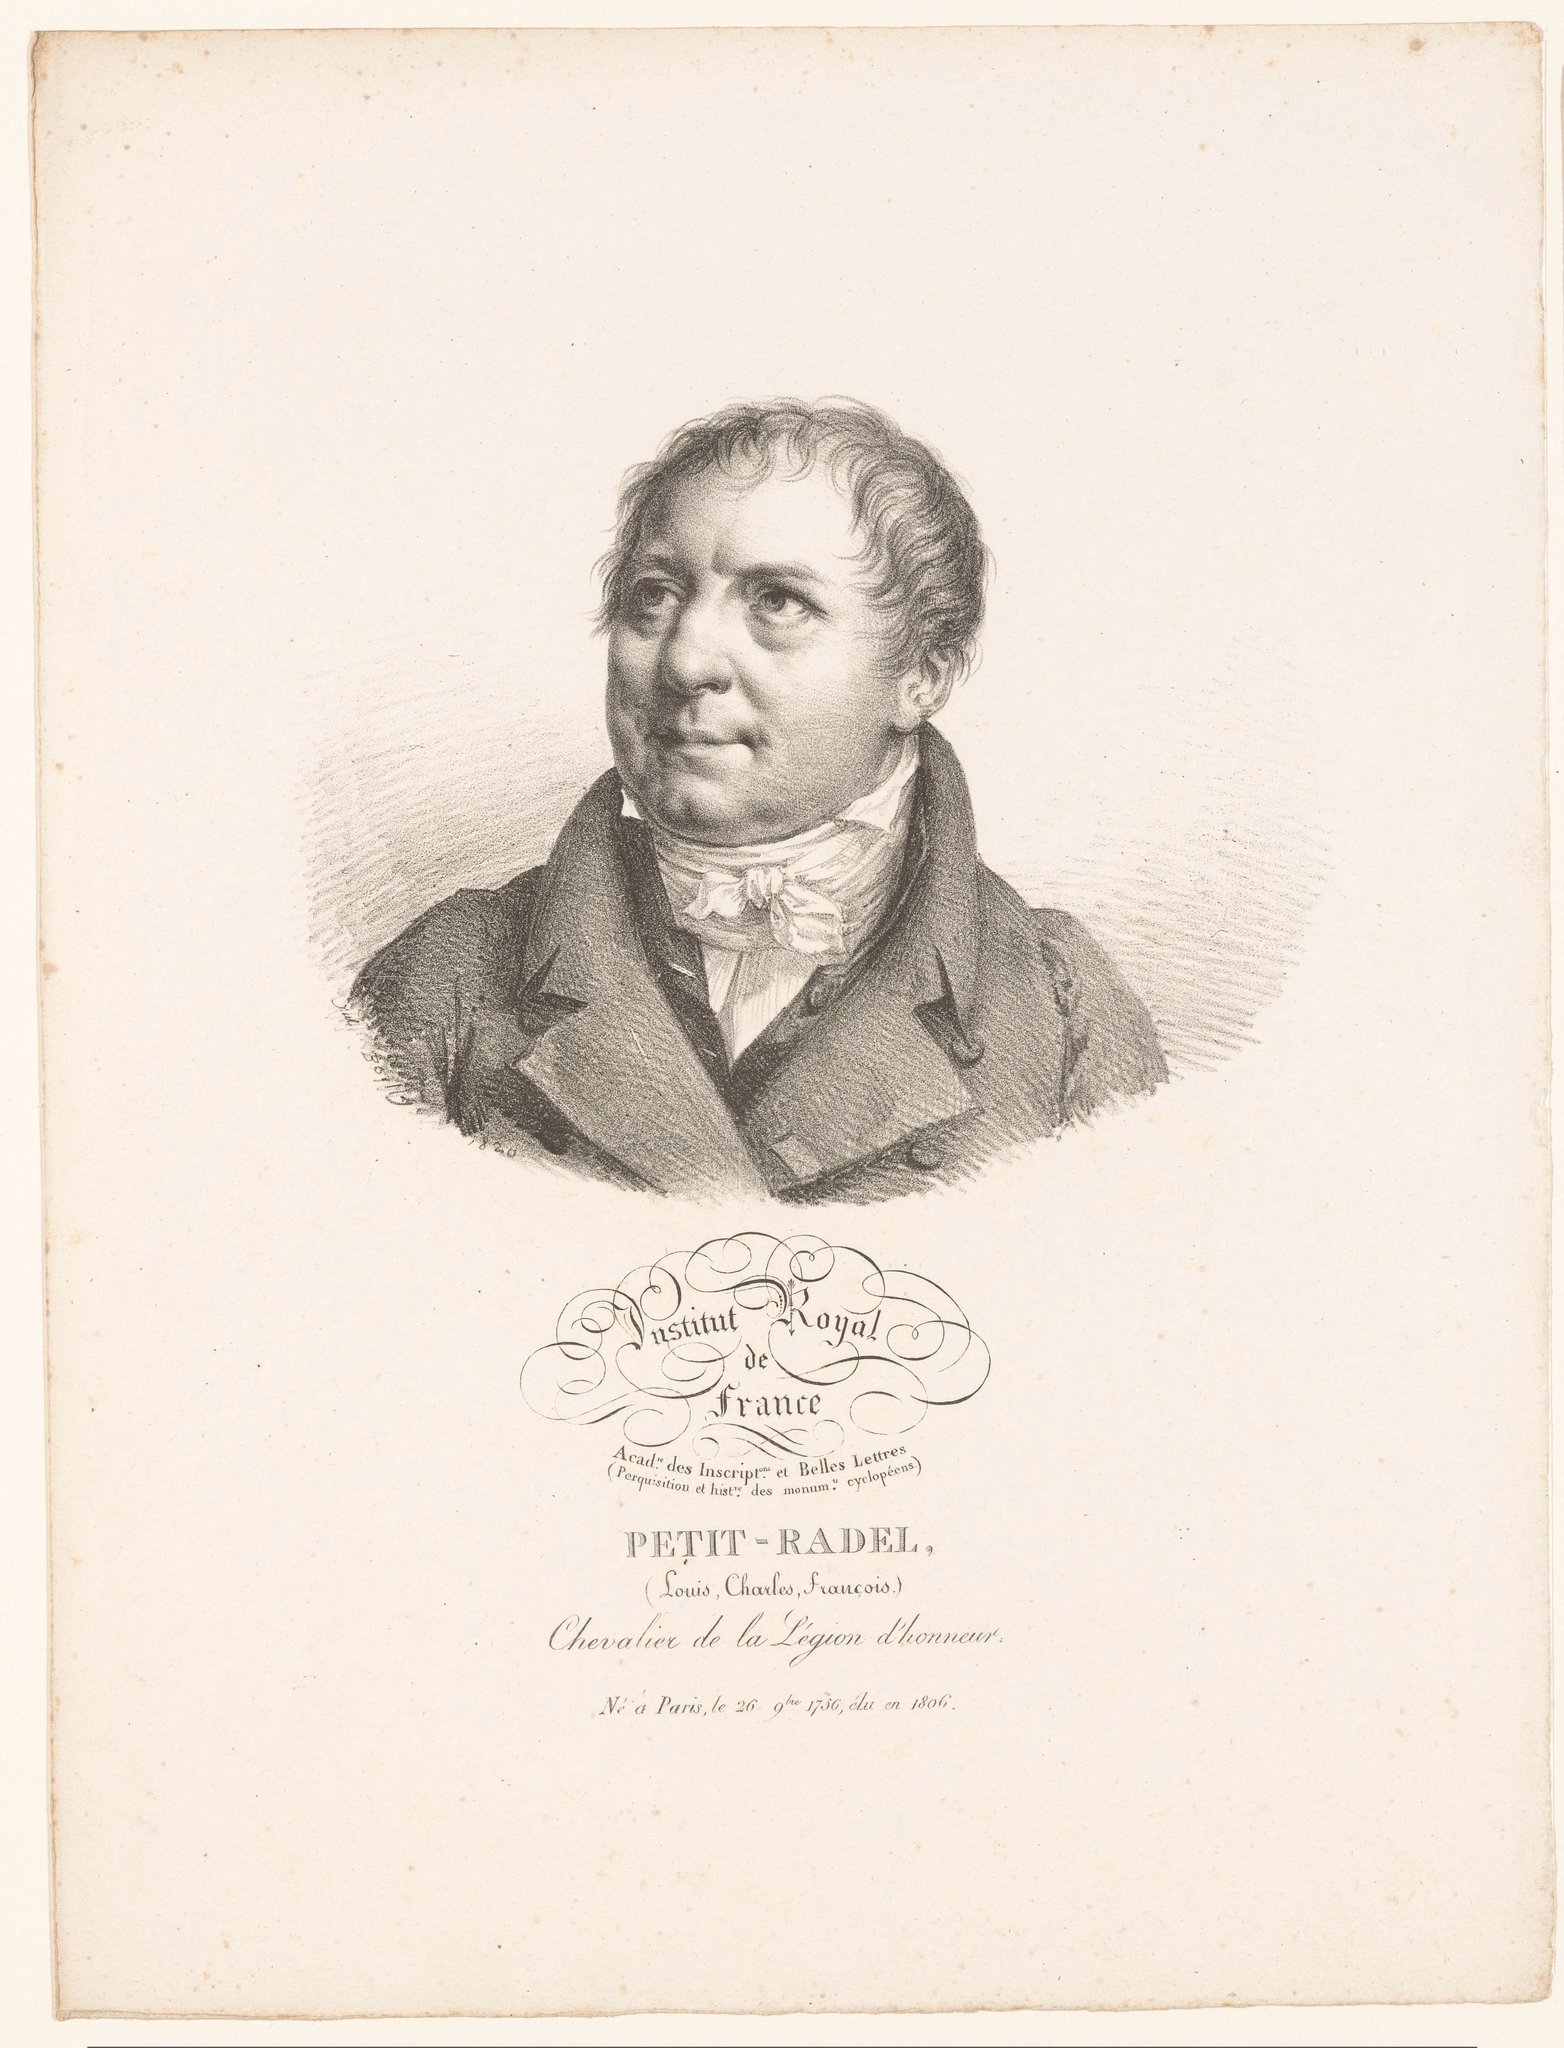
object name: print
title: Petit-Radel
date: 1820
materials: paper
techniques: lithograph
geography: paris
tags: historical persons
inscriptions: collector's mark: Lugt 2228a